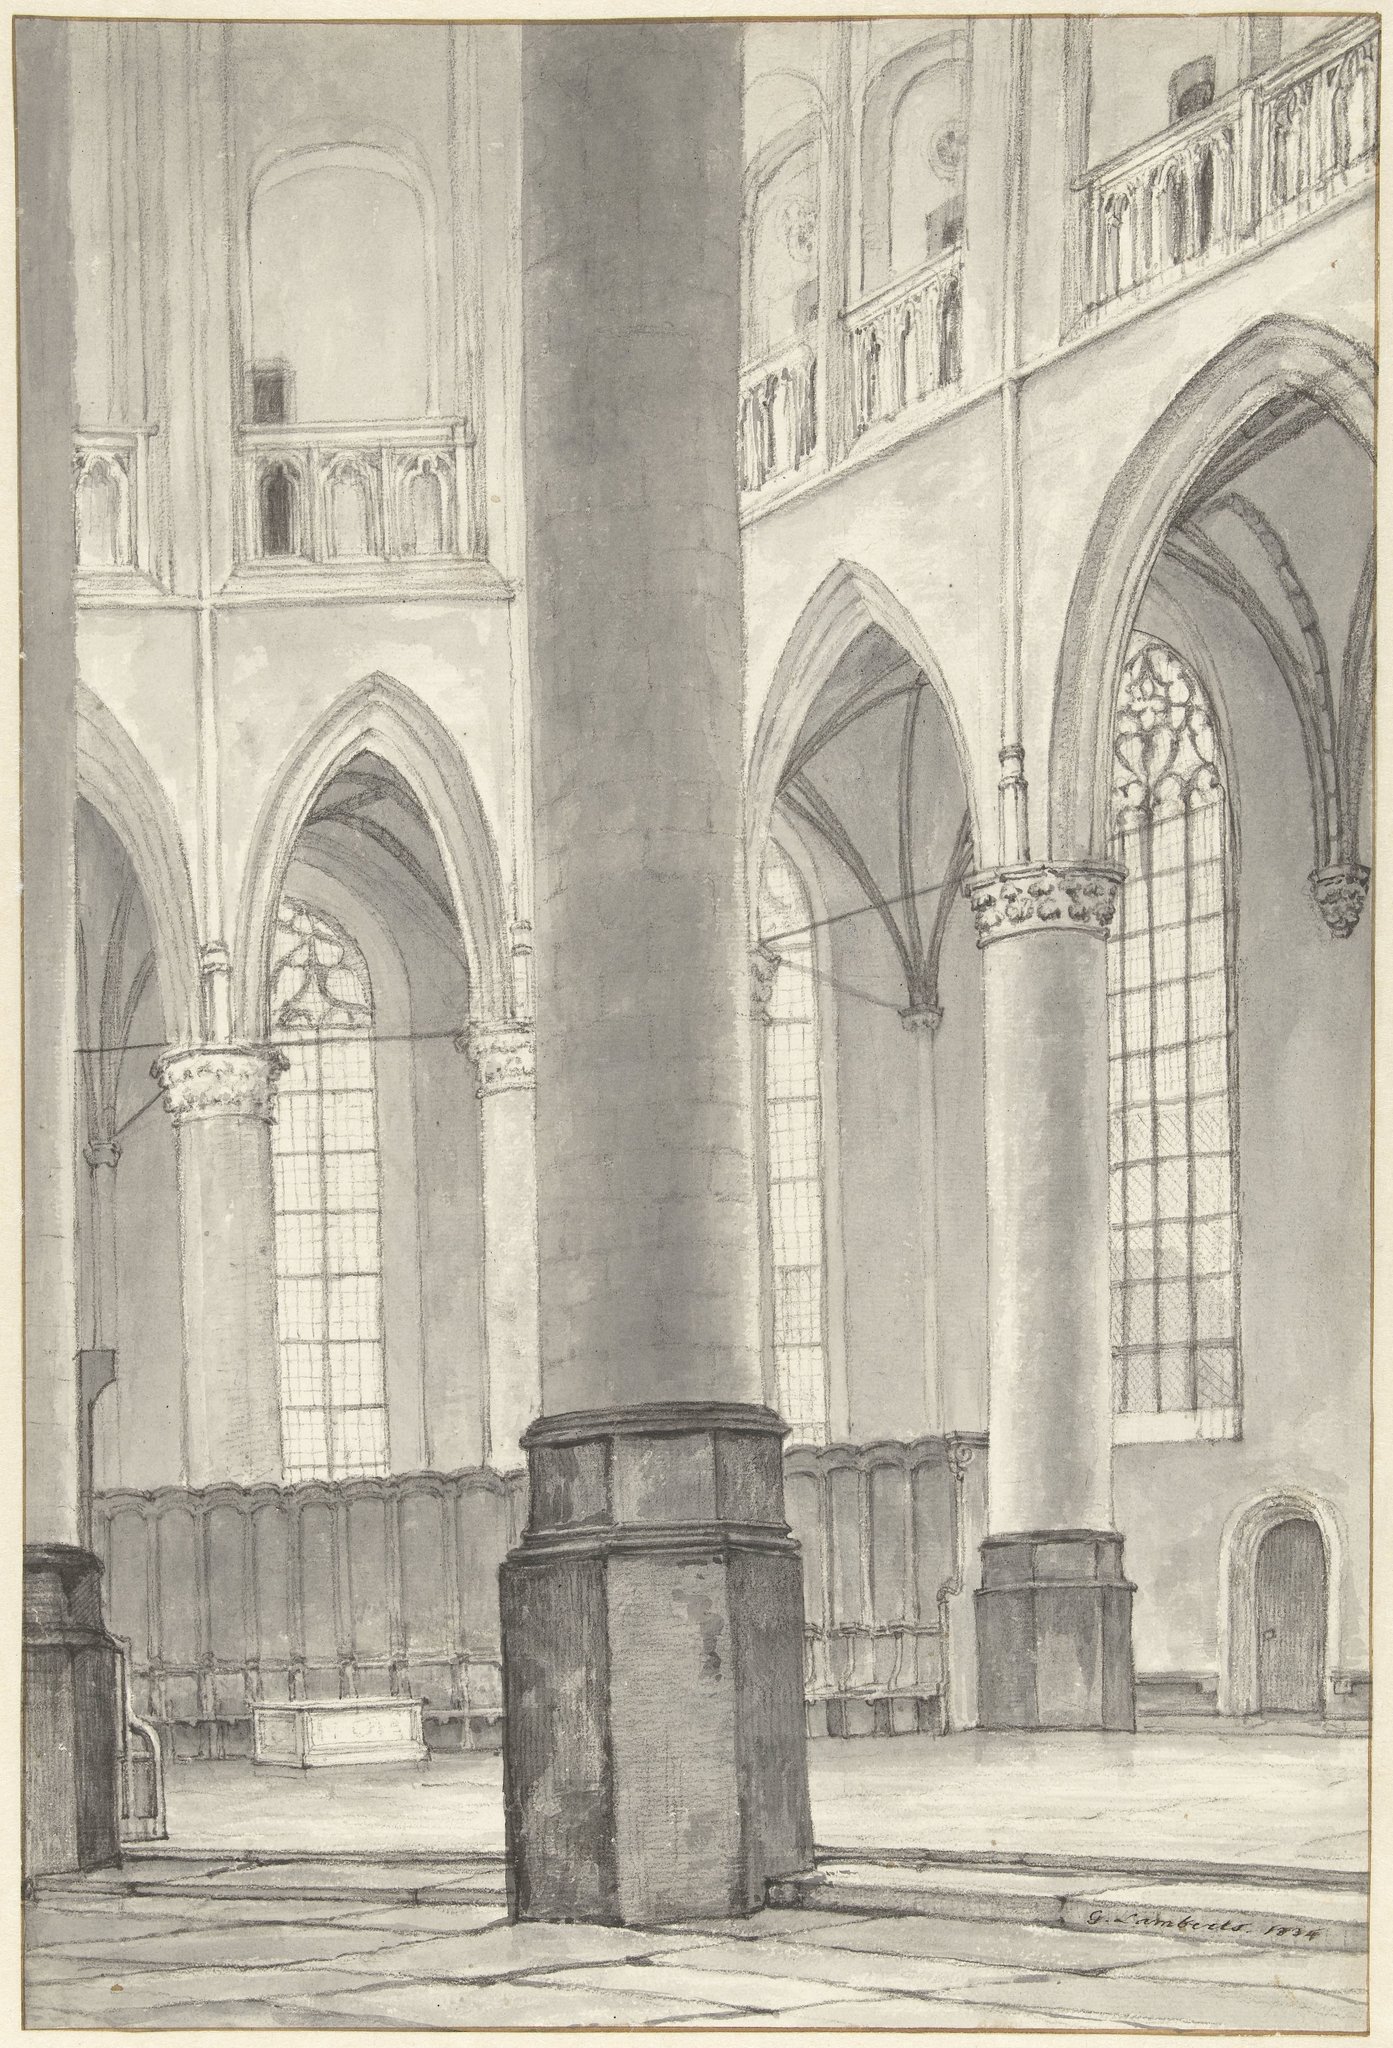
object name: drawing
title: De tombe van Floris V in de Grote Kerk te Alkmaar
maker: gerrit lamberts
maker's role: bookseller, draughtsman, print maker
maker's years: 1776-1850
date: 1834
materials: chalk, paper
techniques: brush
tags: leiden, floris v (graaf van holland en zeeland), interior of church